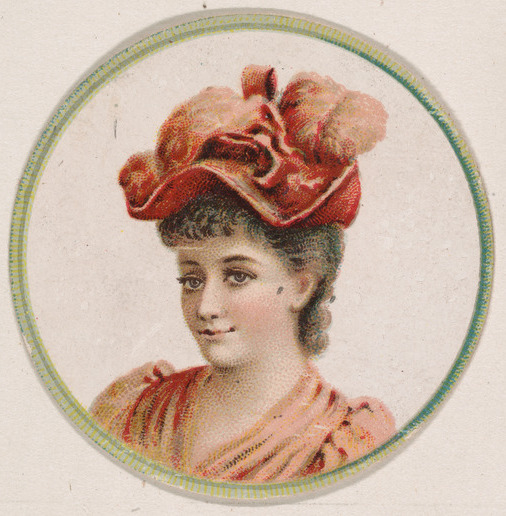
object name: print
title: Woman wearing hat with pink feathers, from the Novelties series (N228, Type 2) issued by Kinney Bros.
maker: kinney brothers tobacco company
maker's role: publisher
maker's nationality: american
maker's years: 1869-2011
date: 1889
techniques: color lithograph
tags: women